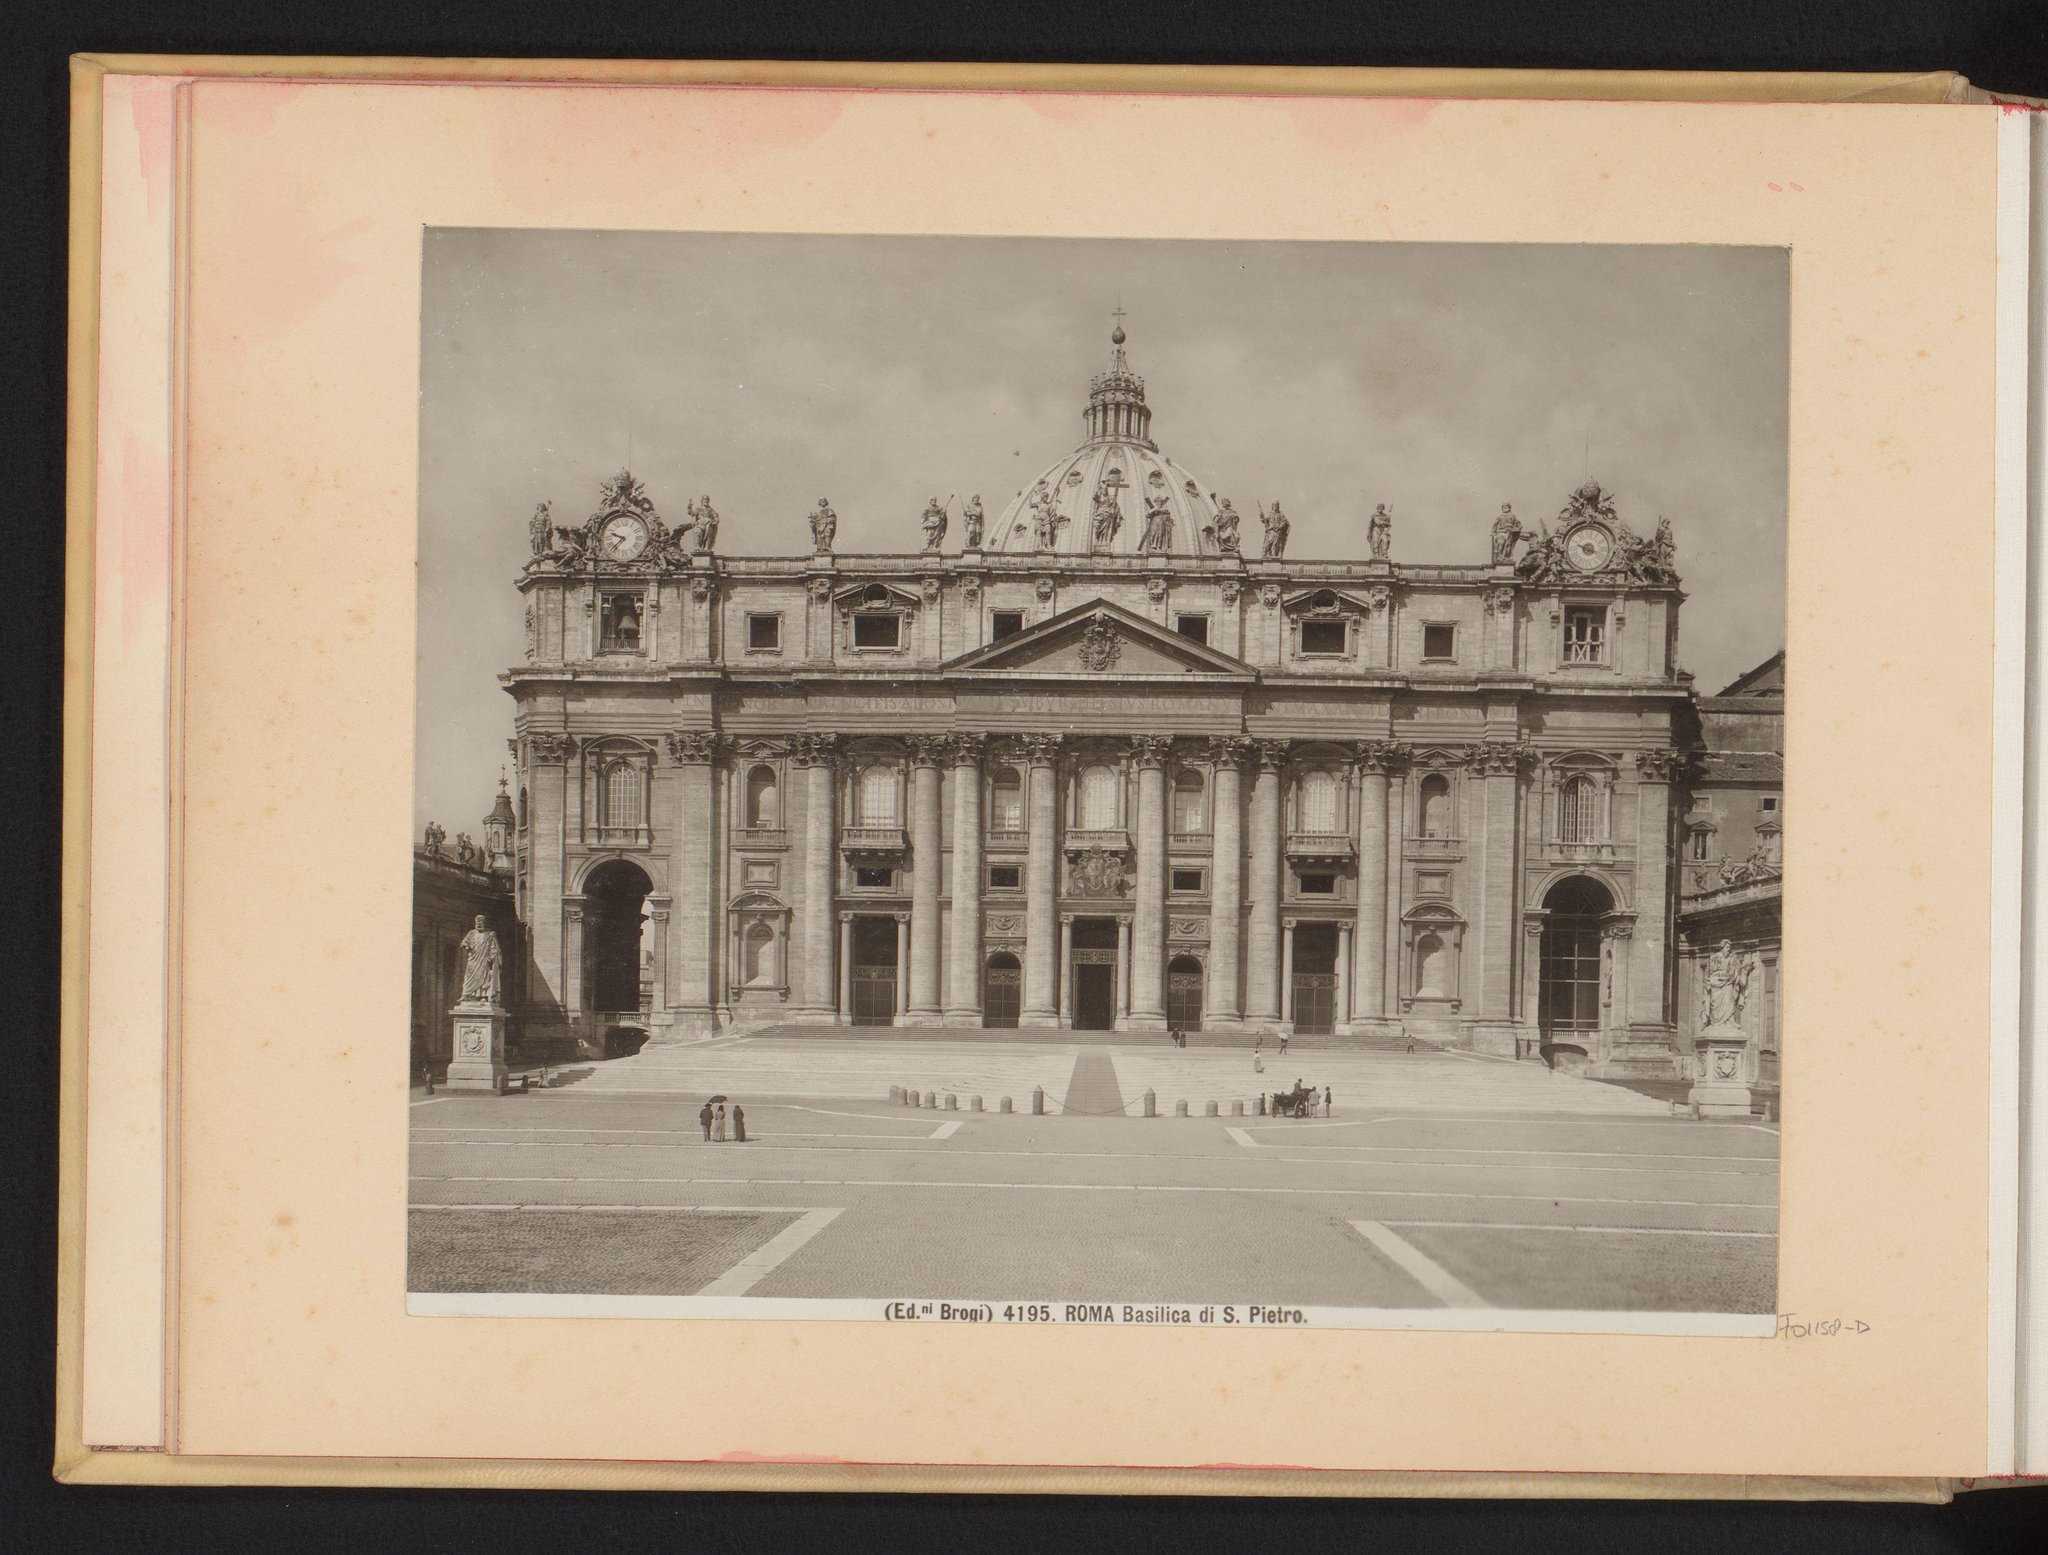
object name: photograph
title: Voorgevel van de Sint-Pietersbasiliek te Vaticaanstad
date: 1875-1907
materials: photographic support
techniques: gelatin silver print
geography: sint-pietersplein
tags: church (exterior)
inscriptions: number: ‘4195’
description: Onderdeel van Fotoalbum met opnames van bezienswaardigheden en kunstwerken in Italië.